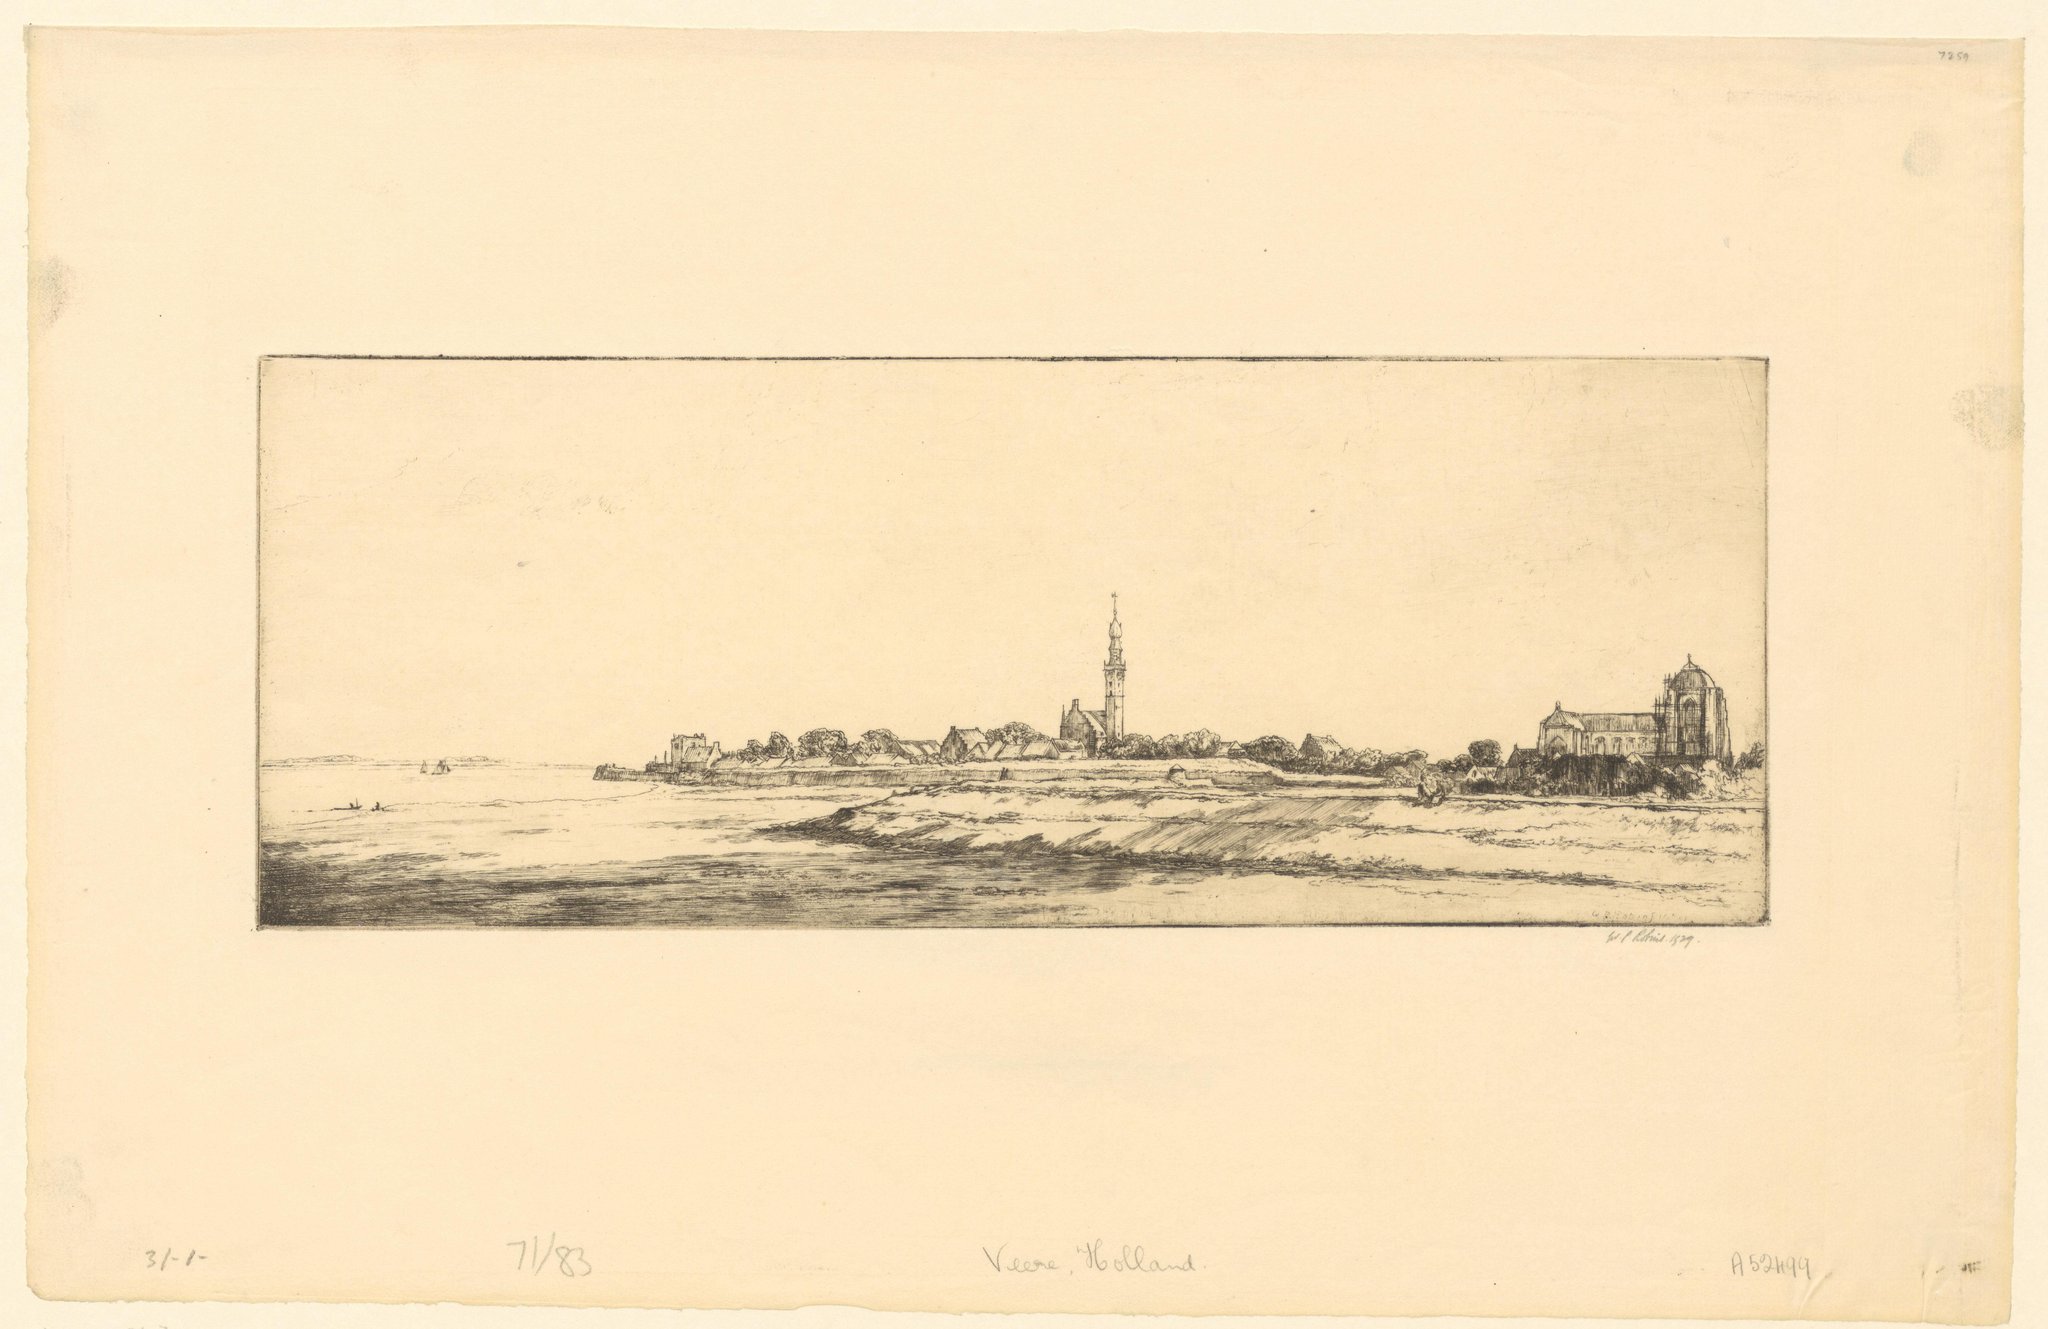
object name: print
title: Veere, Holland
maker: william palmer robins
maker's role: print maker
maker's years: 1882-1959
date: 1929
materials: paper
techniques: drypoint, etching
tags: prospect of city, town panorama, silhouette of city (+ city(-scape) with figures, staffage)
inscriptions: collector's mark: Lugt 2760, collector's mark: Lugt 2228, annotation: ‘A 52499’